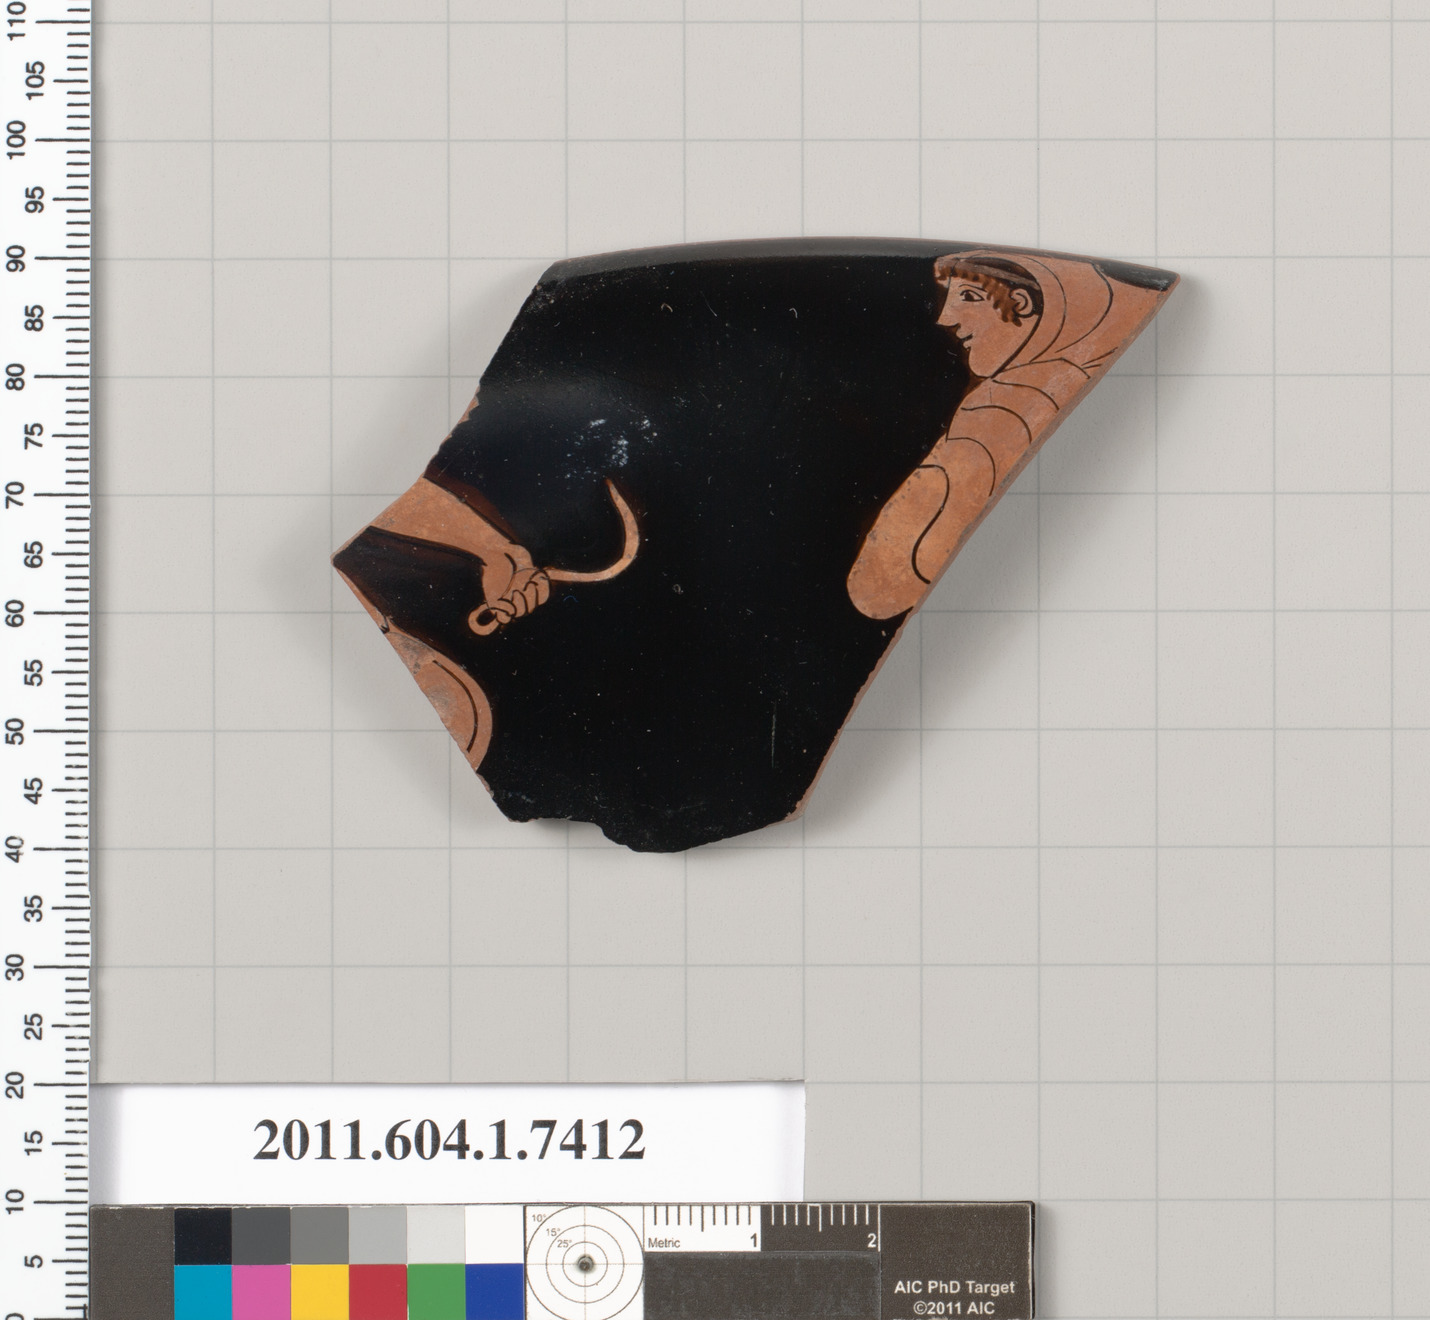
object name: kylix fragment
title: Terracotta rim fragment of a kylix (drinking cup)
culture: greek, attic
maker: clinic painter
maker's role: artist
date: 490-470 BCE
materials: terracotta